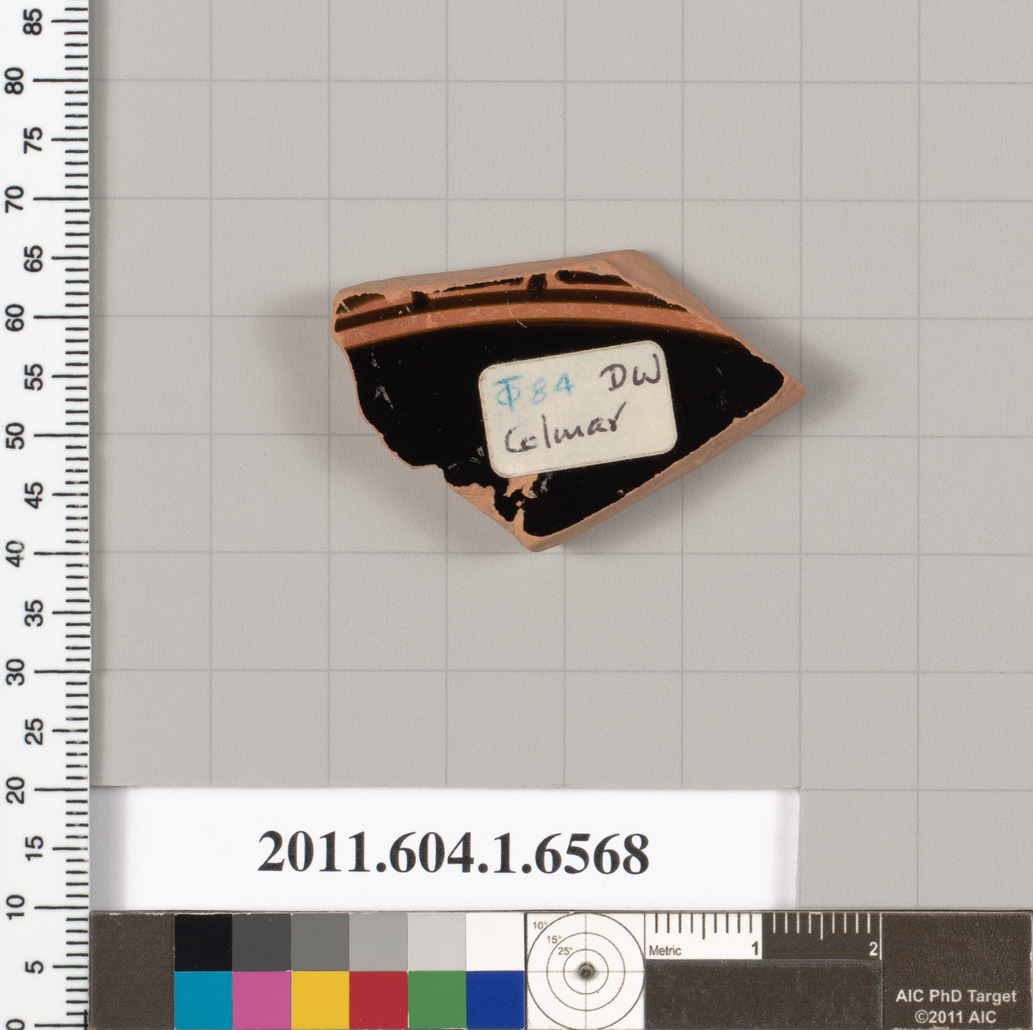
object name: kylix fragment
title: Terracotta fragment of a kylix (drinking cup)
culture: greek, attic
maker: colmar painter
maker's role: artist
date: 490-480 BCE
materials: terracotta